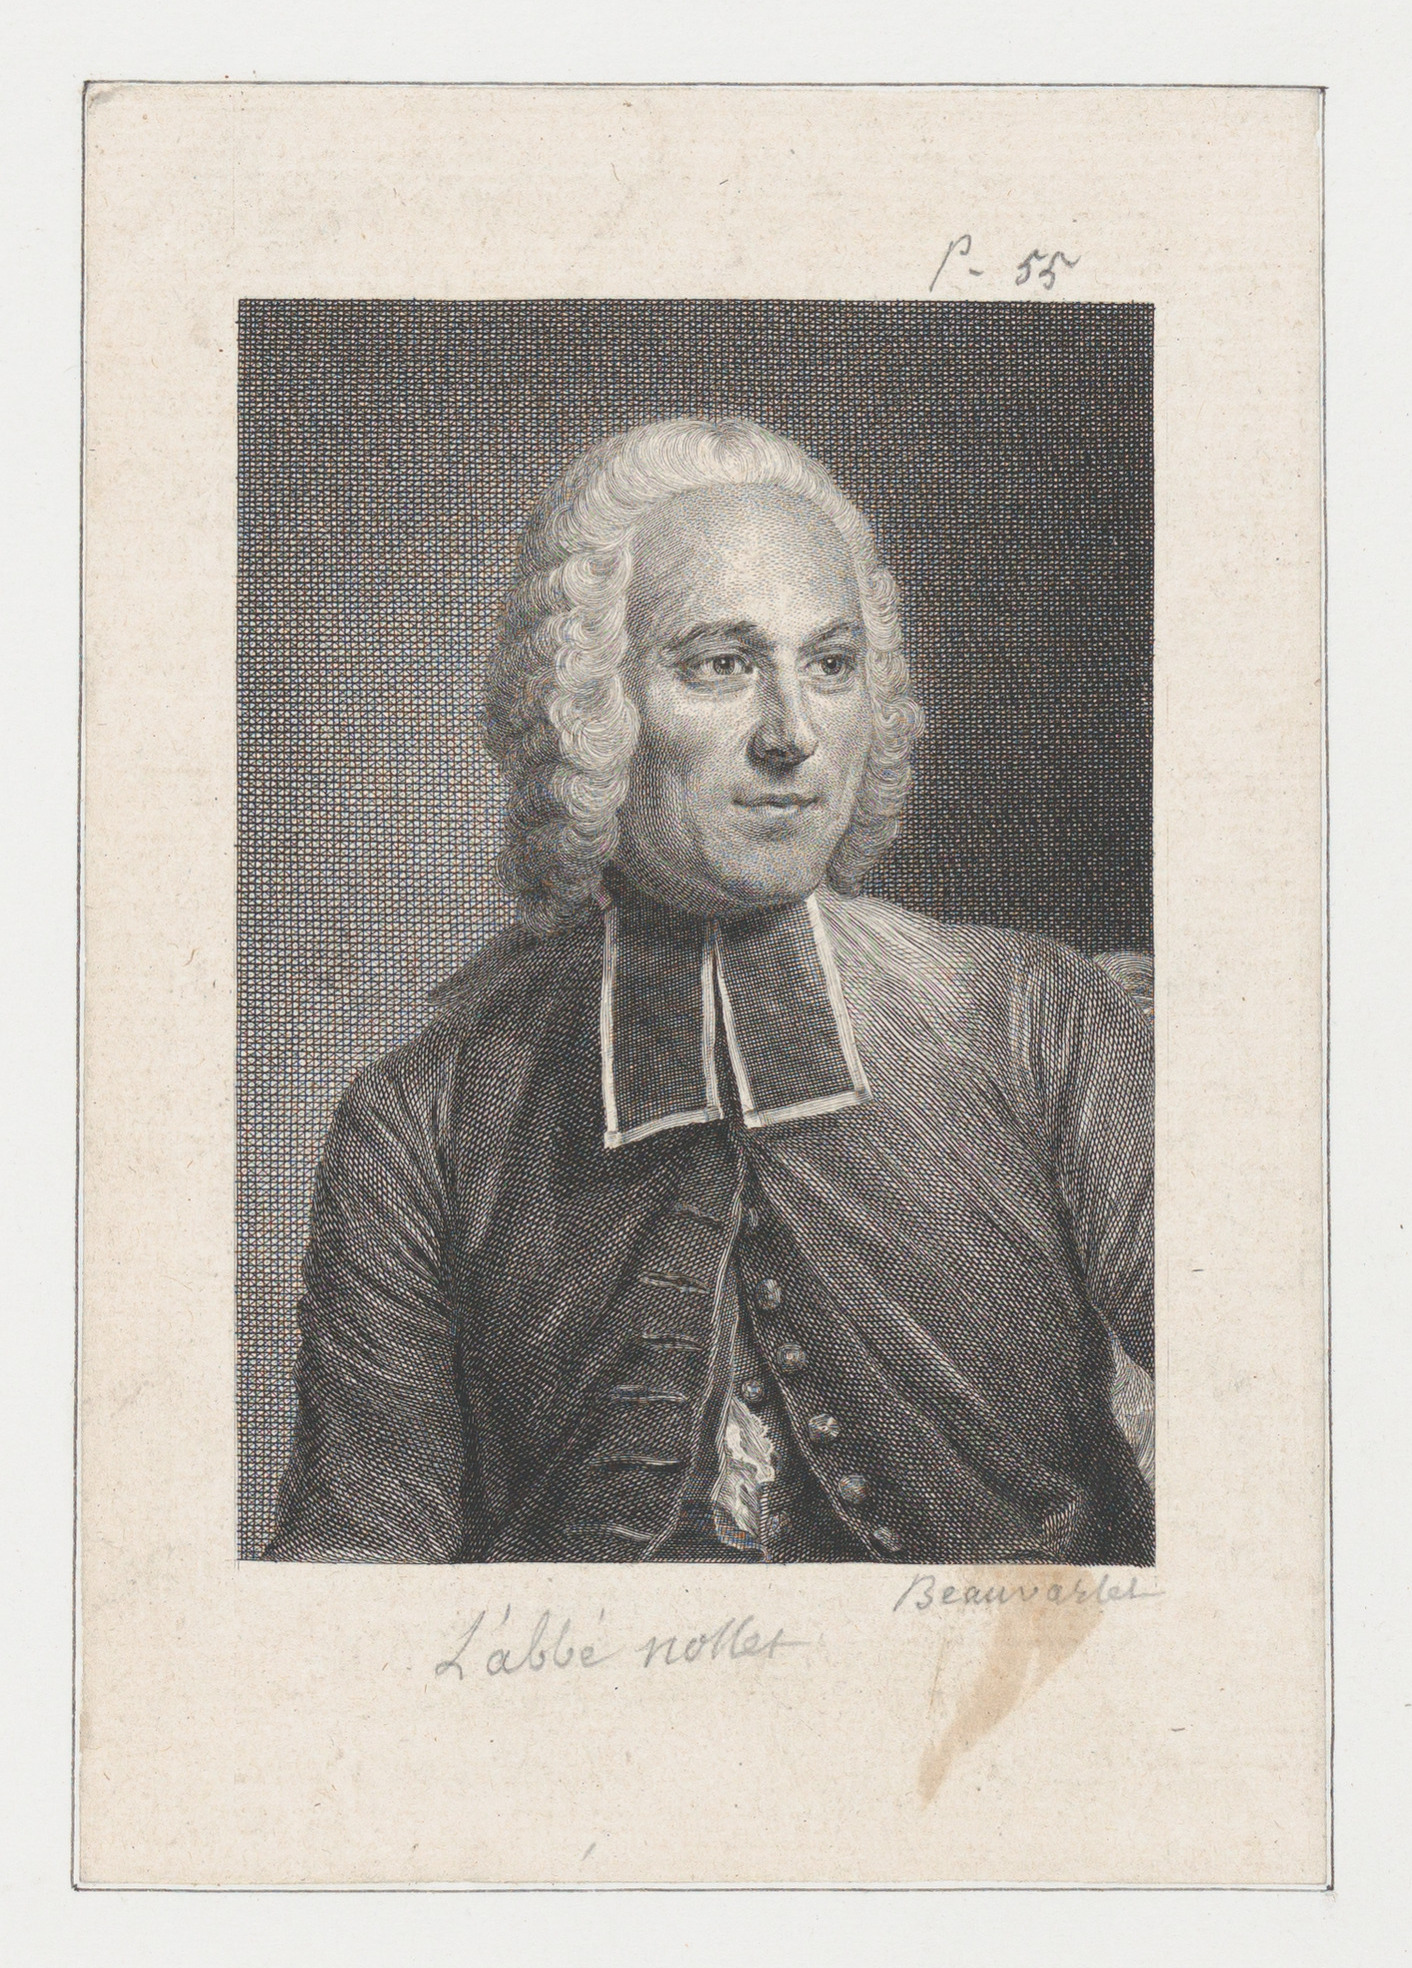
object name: print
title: Portrait of Jean Antoine Nollet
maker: jacques firmin beauvarlet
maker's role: etcher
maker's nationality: french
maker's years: 1731-1797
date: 1750-1795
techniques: etching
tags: men,portraits